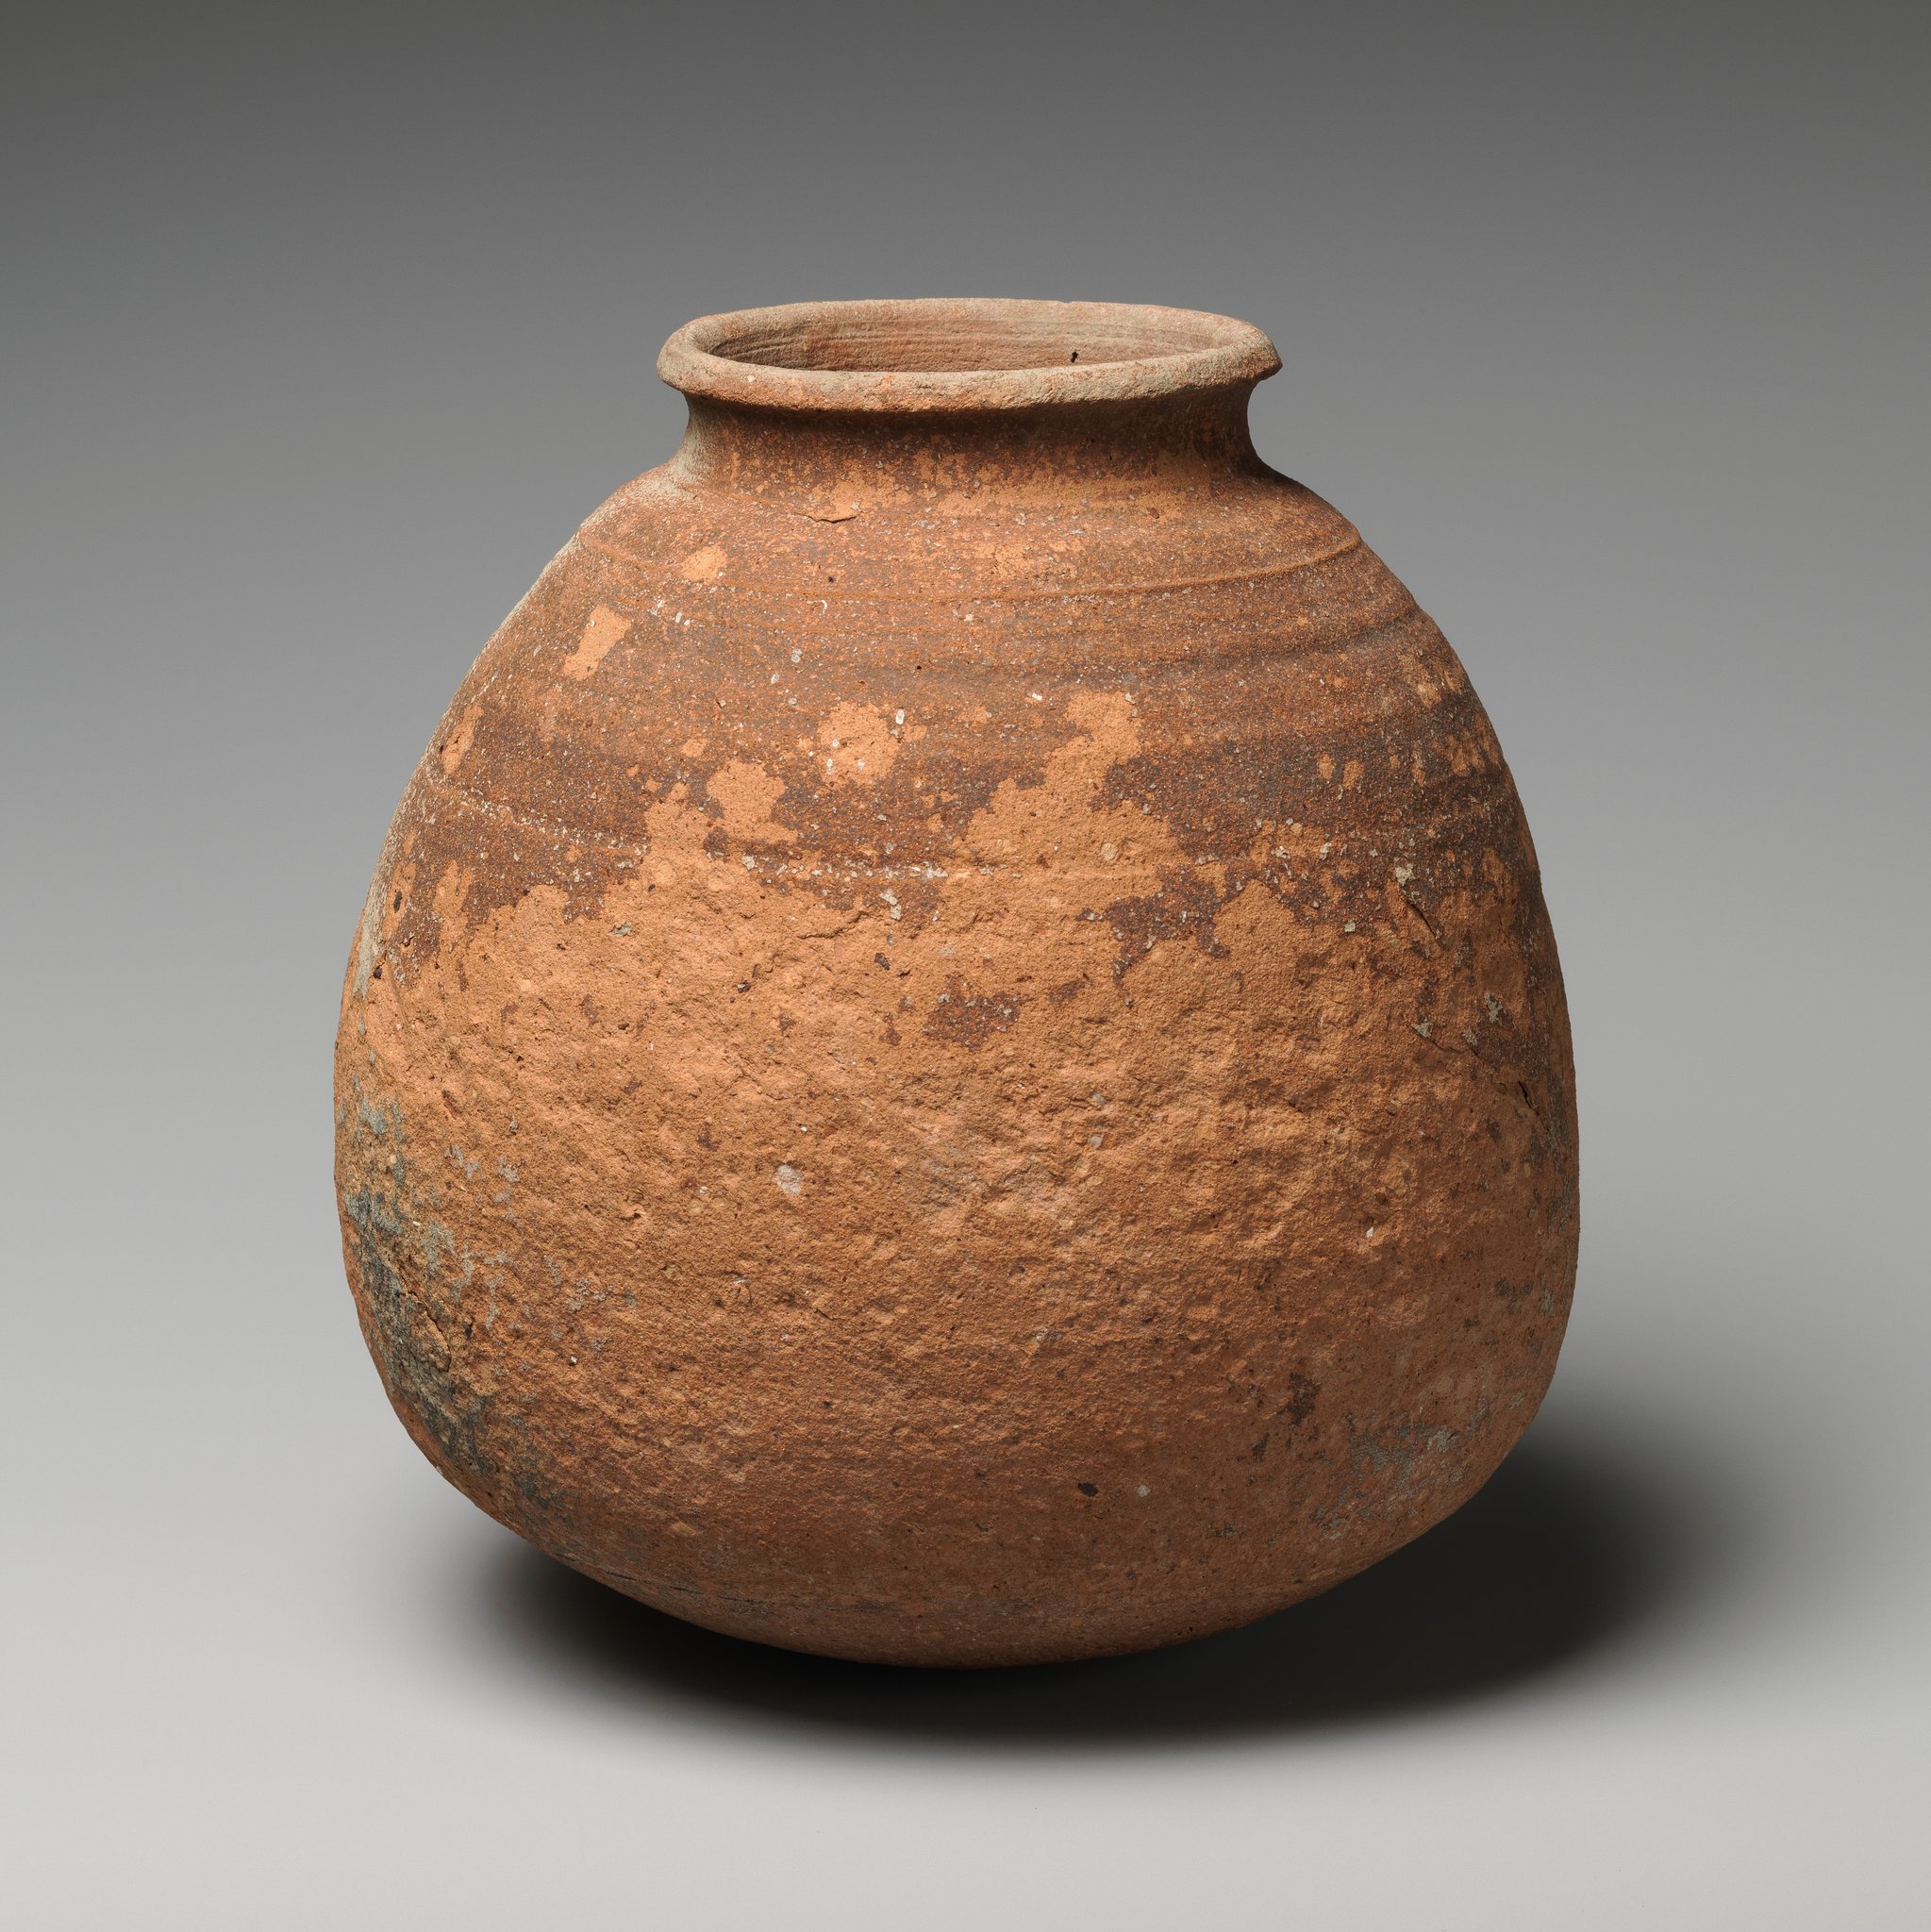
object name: pot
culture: coptic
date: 400 BCE-400 CE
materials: earthenware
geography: egypt